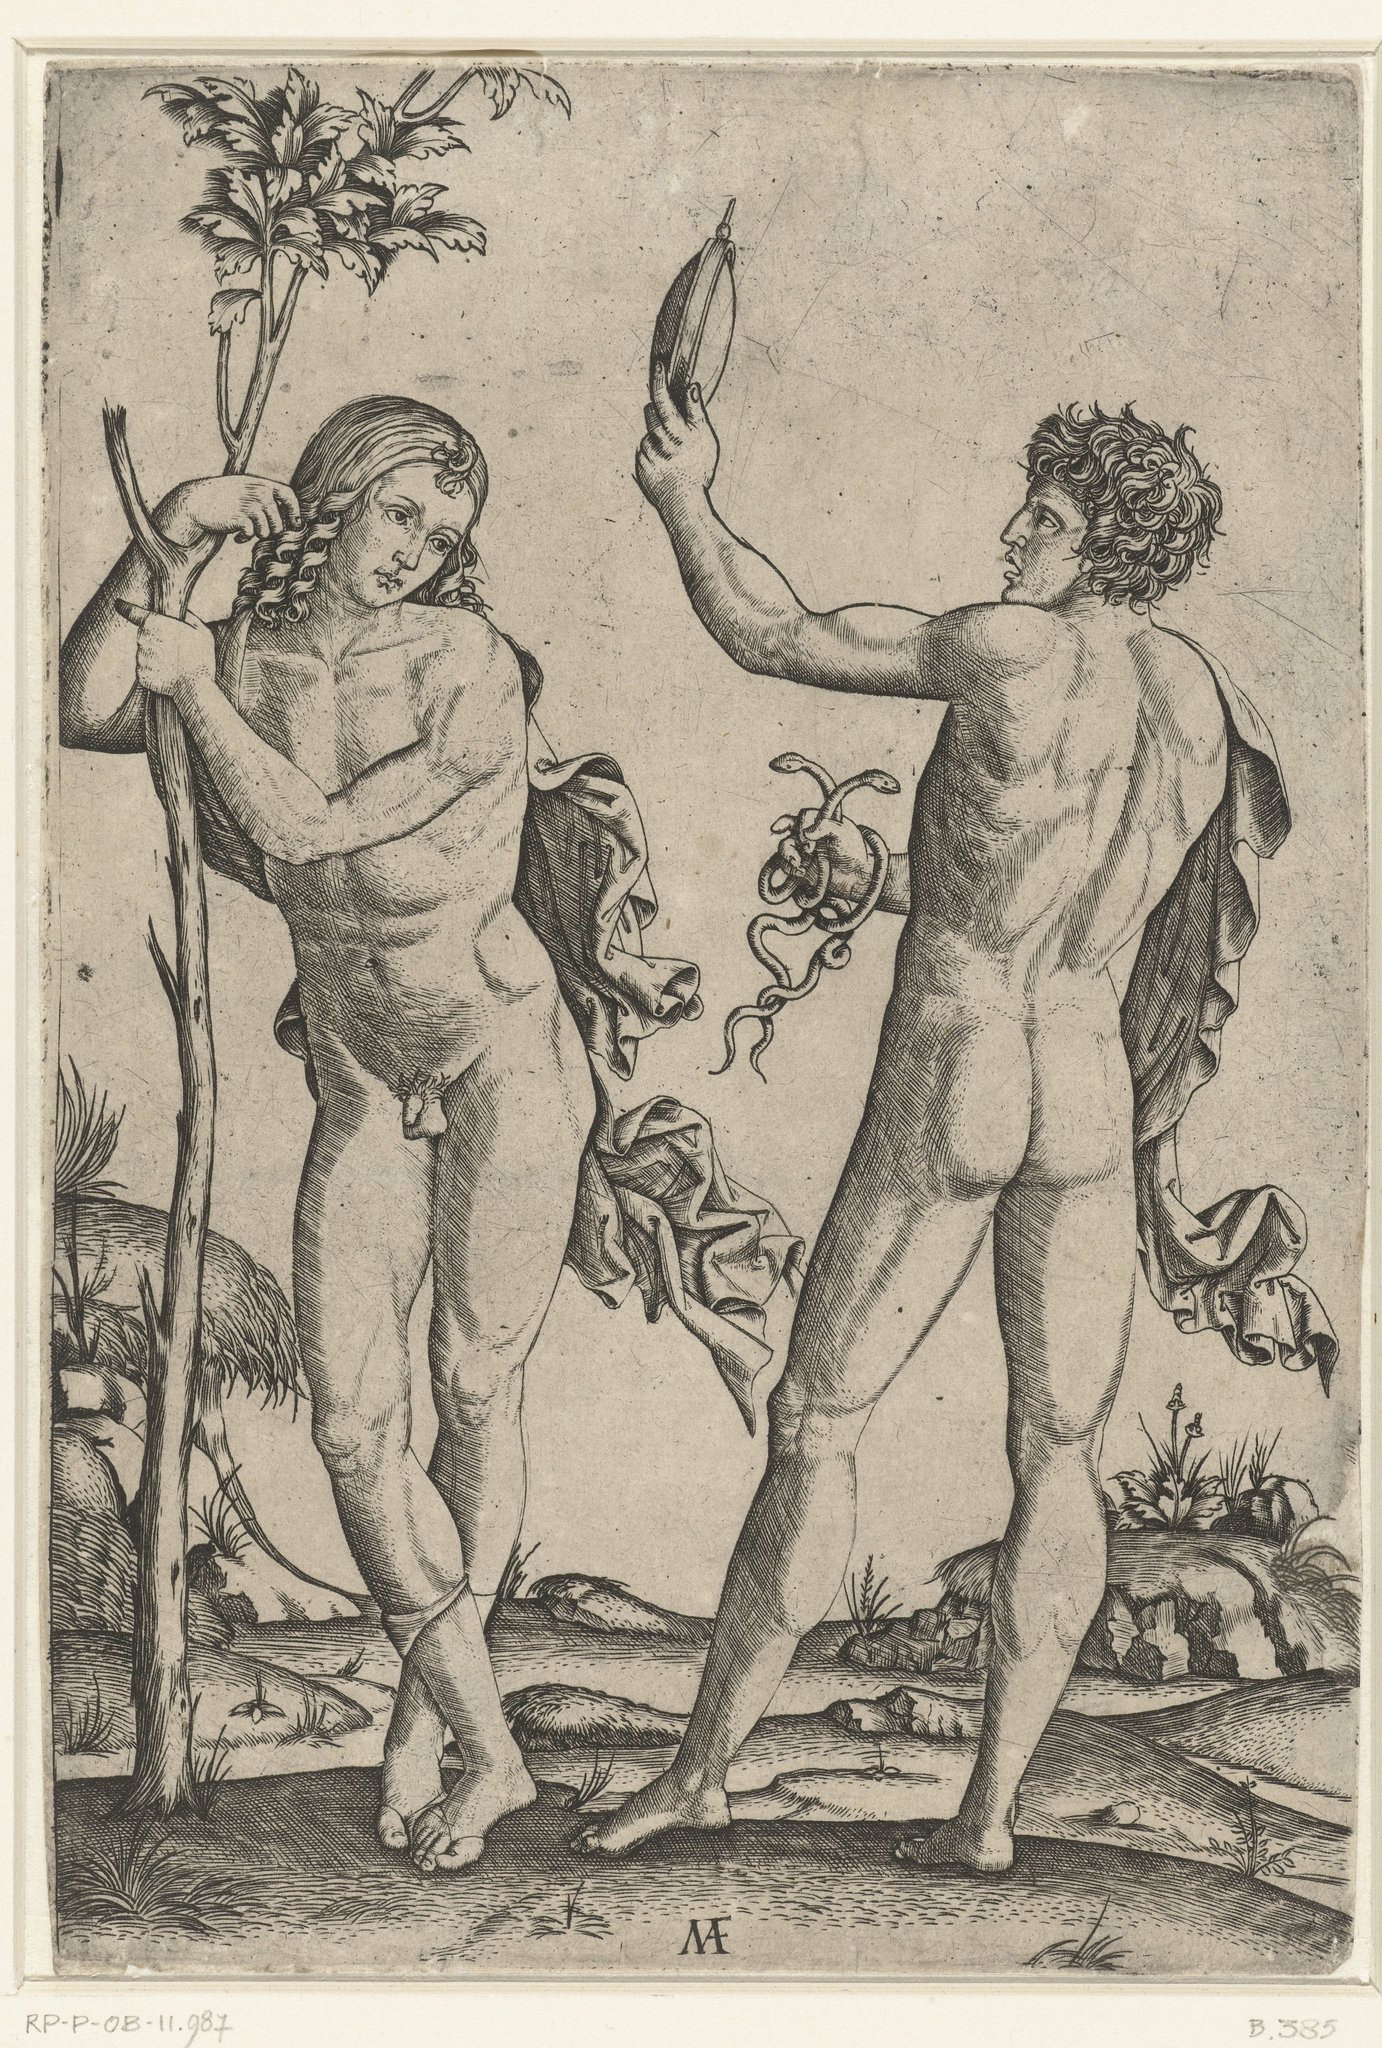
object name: print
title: Naakte man leunend tegen boom en naakte man met spiegel en twee slangen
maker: marcantonio raimondi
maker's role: print maker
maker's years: 1470-1534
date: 1510-1527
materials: paper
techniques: engraving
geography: italy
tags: snakes, looking in the mirror; contemplation of own beauty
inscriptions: collector's mark: Lugt 240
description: De man met twee slangen in zijn hand bekijkt ijn gezicht in een handspiegel.